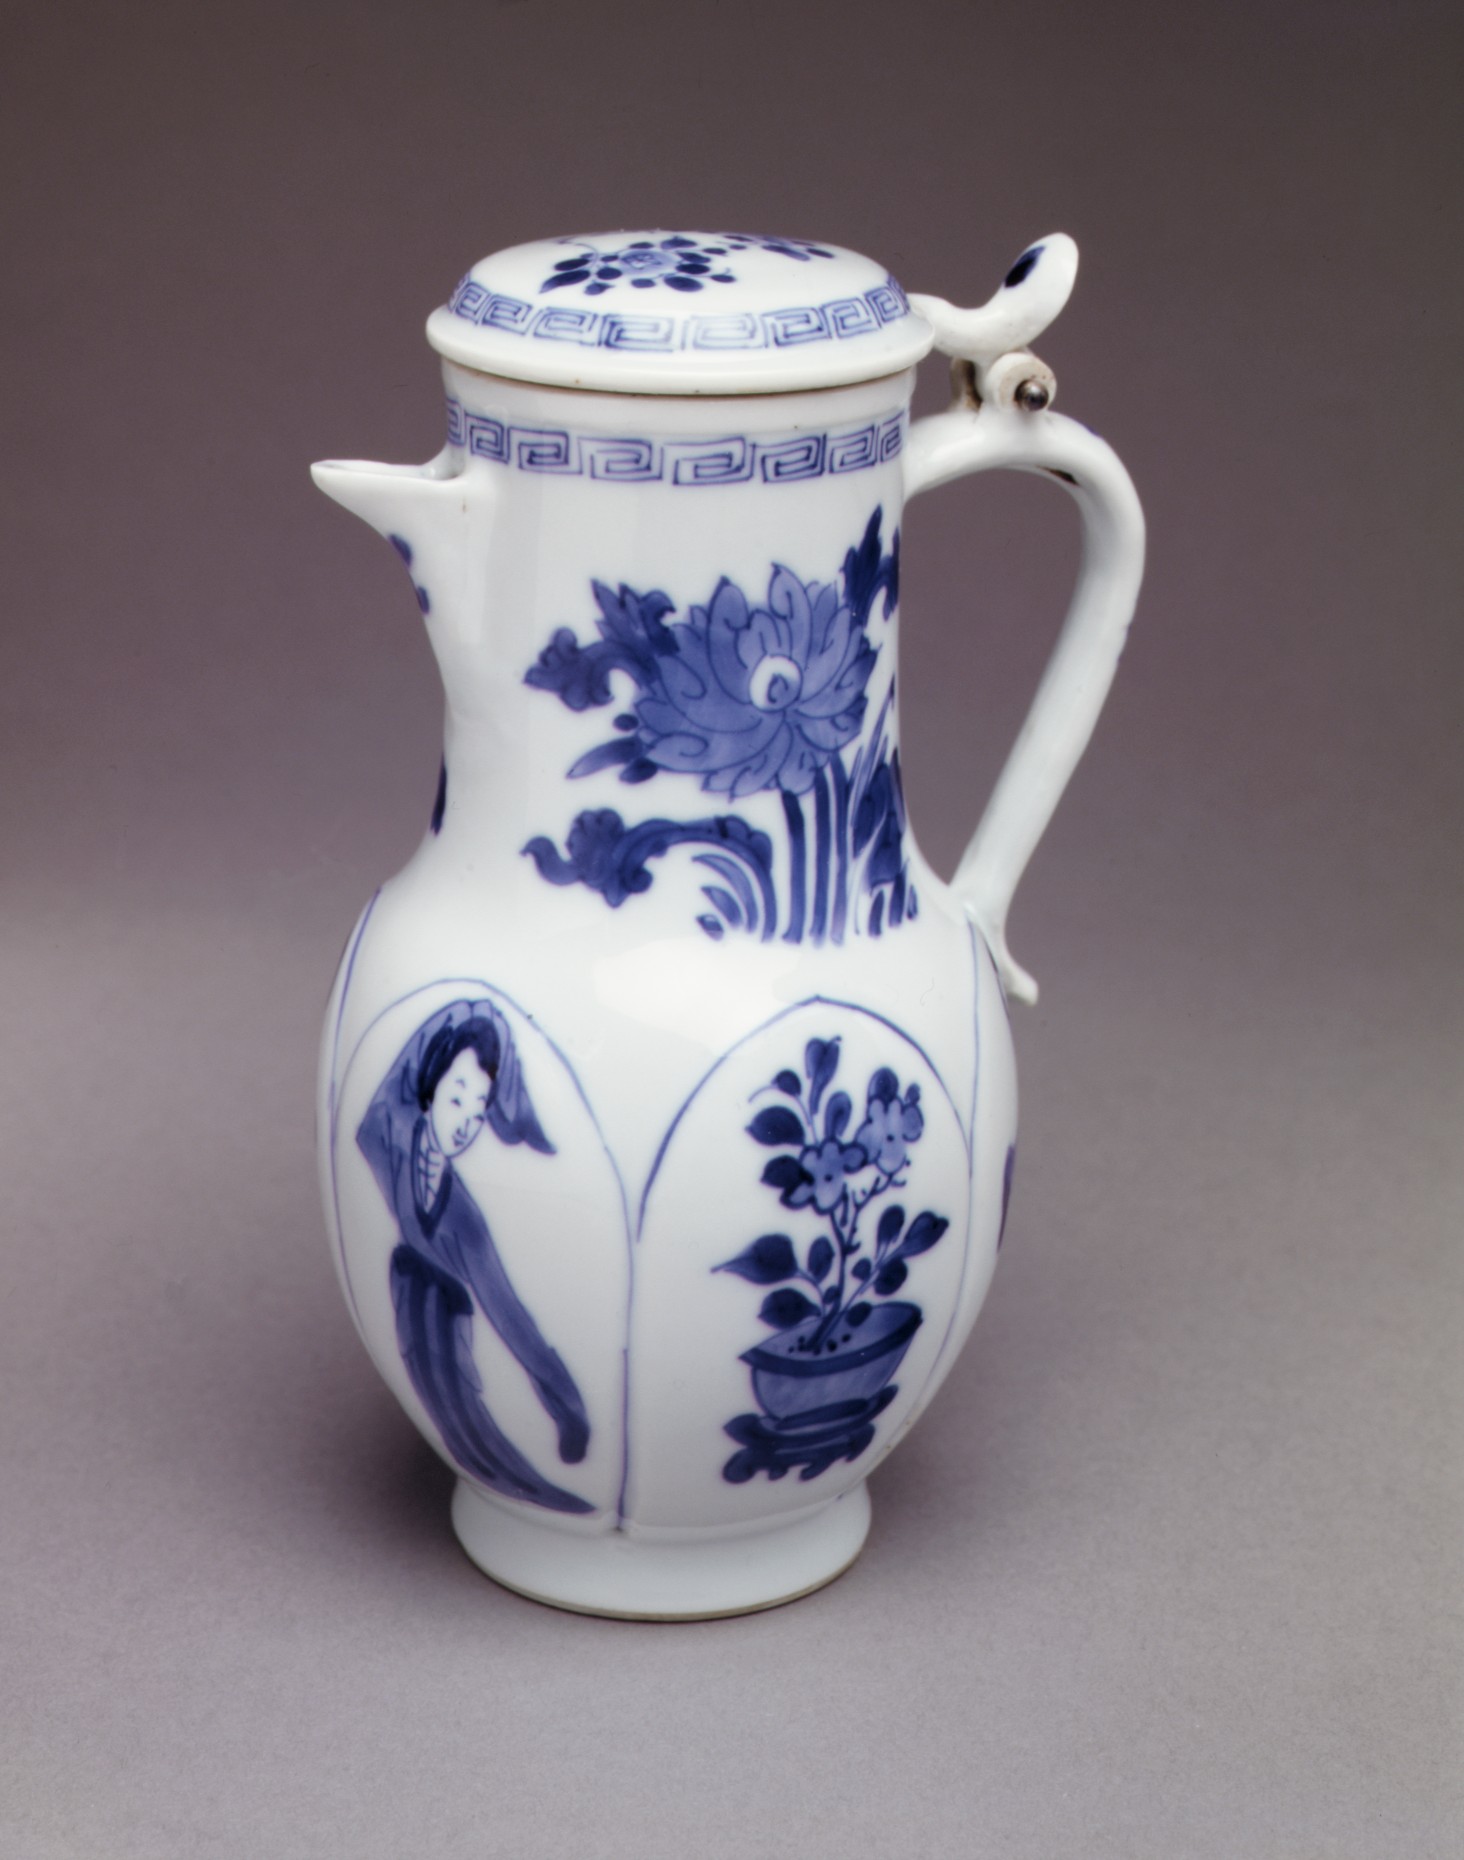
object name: ewer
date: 1715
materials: hard paste porcelain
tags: women,flowers